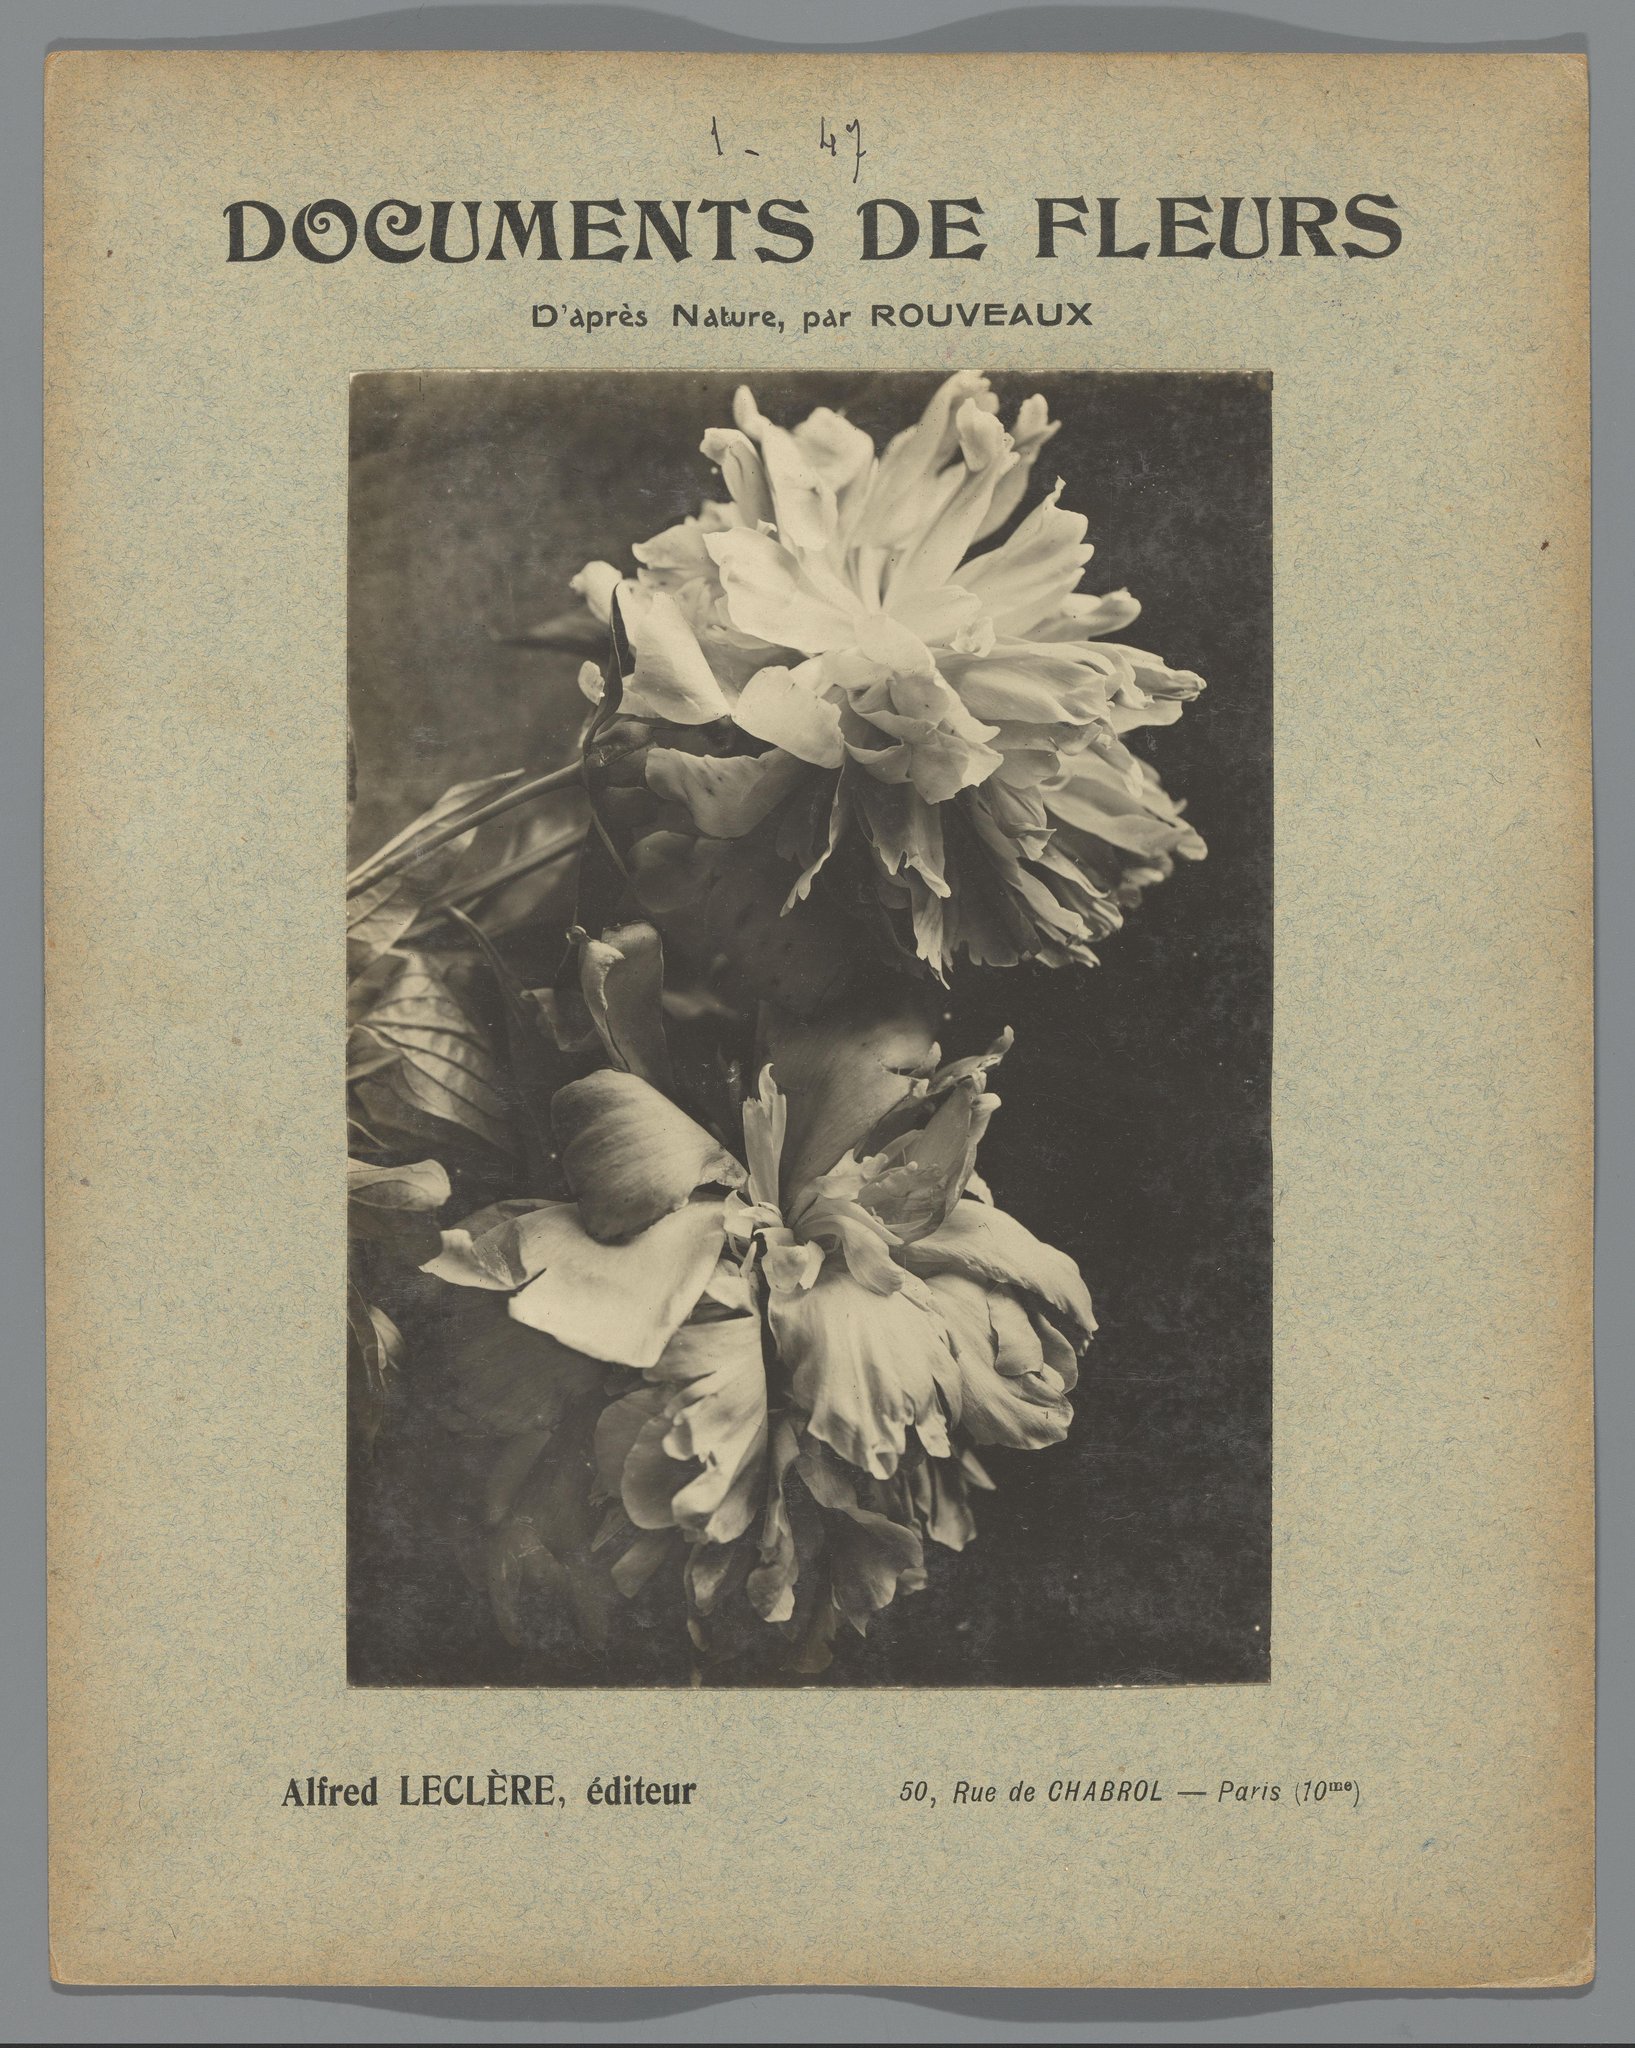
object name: photograph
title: Bloemstudie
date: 1895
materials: photographic support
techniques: gelatin silver print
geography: france